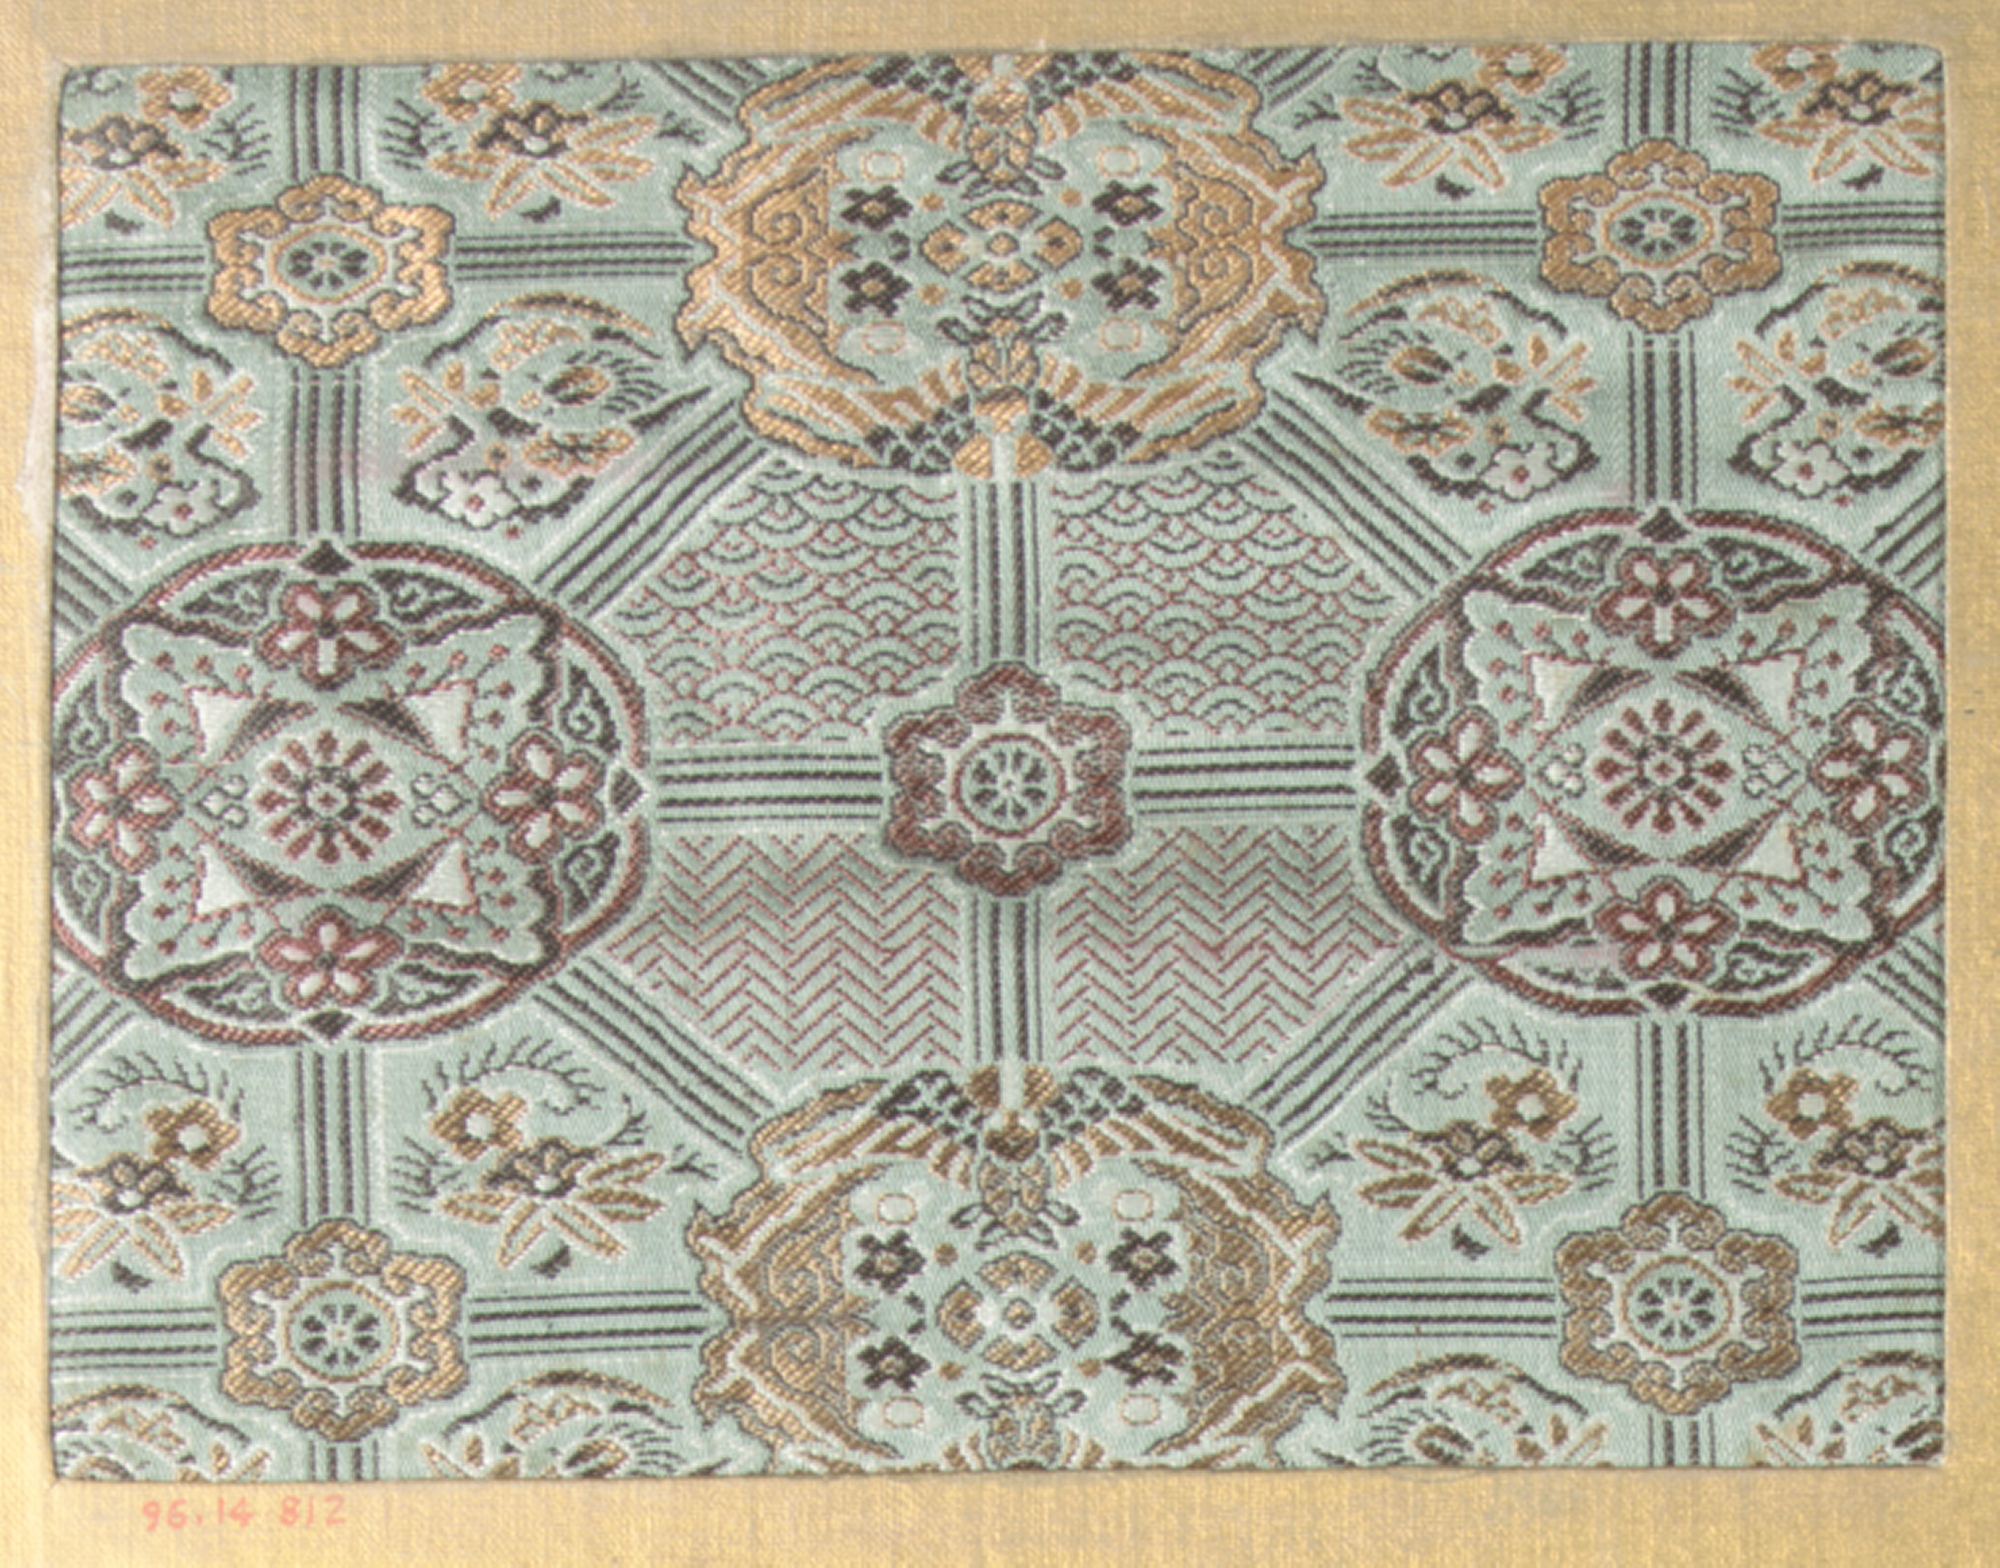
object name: piece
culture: japanese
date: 1701-1900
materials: silk